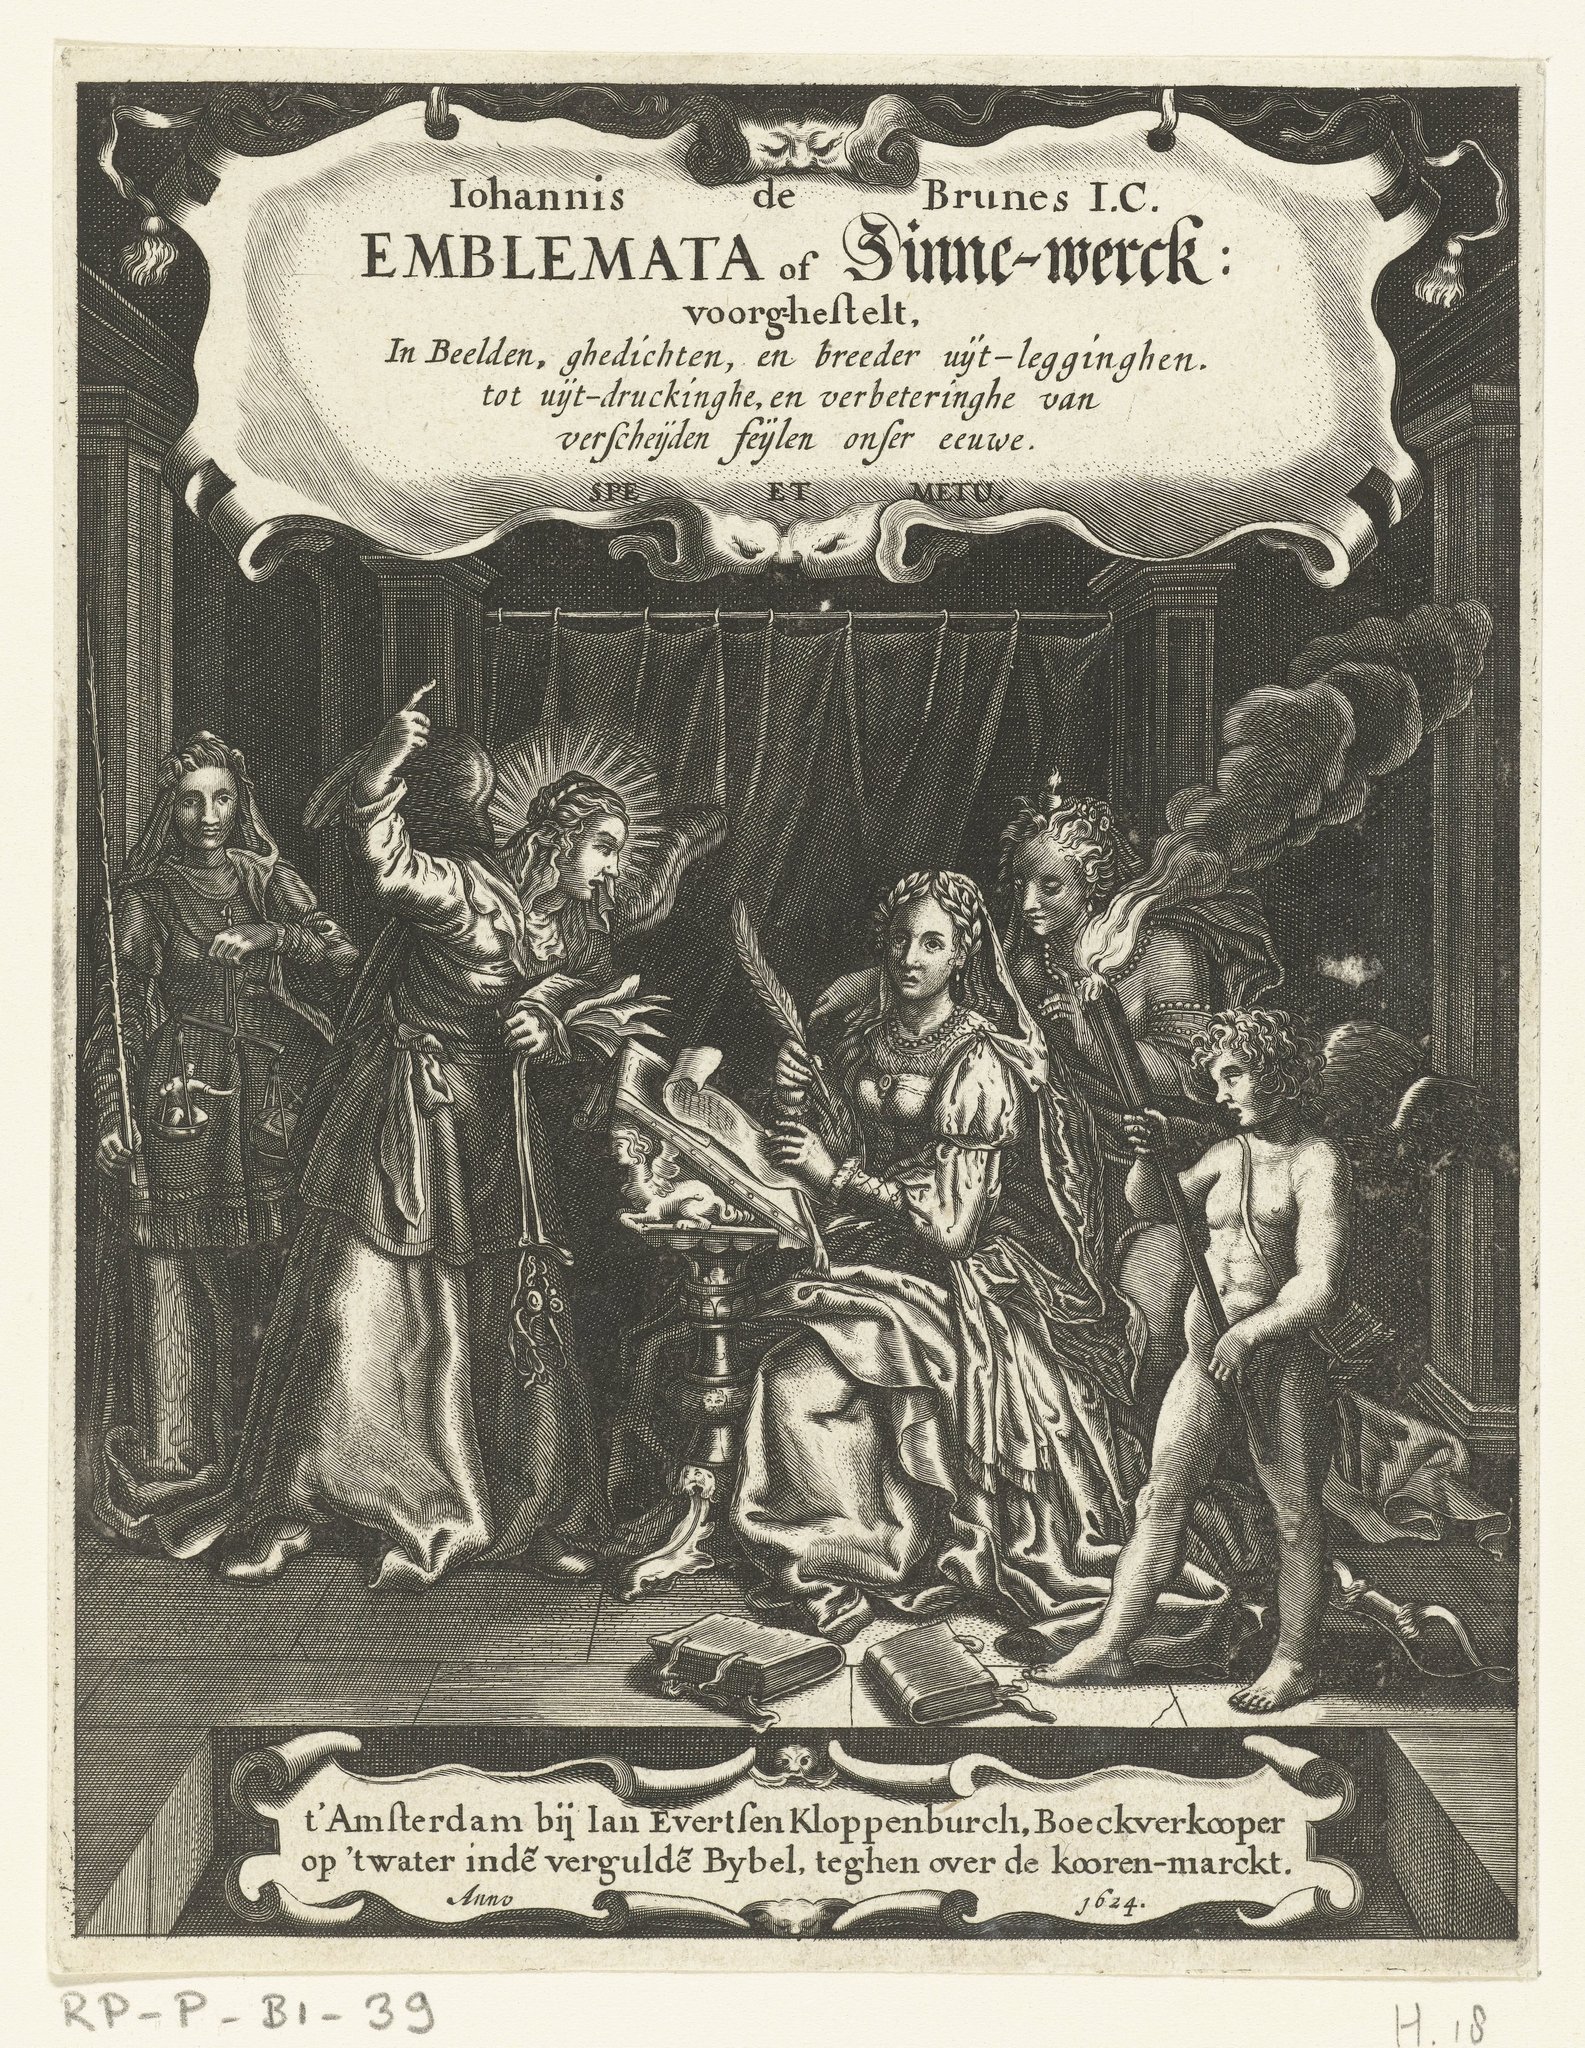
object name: print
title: Emblemata of Zinne-werck: voorghestelt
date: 1624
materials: paper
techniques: engraving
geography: amsterdam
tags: title-page, (story of) cupid, amor (eros), abstract ideas and concepts (+ emblematical representation of concept)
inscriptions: collector's mark: Lugt 2228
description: Vier vrouwen in een donkere kamer vergezeld door Amor die met een fakkel de ruimte verlicht. Een van de vrouwen zit aan een lessenaar te schrijven, een andere kijkt over haar schouder mee. De derde vrouw met een stralenkrans om haar hoofd en vleugels, in haar hand een boek en een paardetoom, vertelt de zittende vrouw opgewonden iets. De vierde vrouw, met een palmtak en een weegschaal staat op haar beurt te wachten.